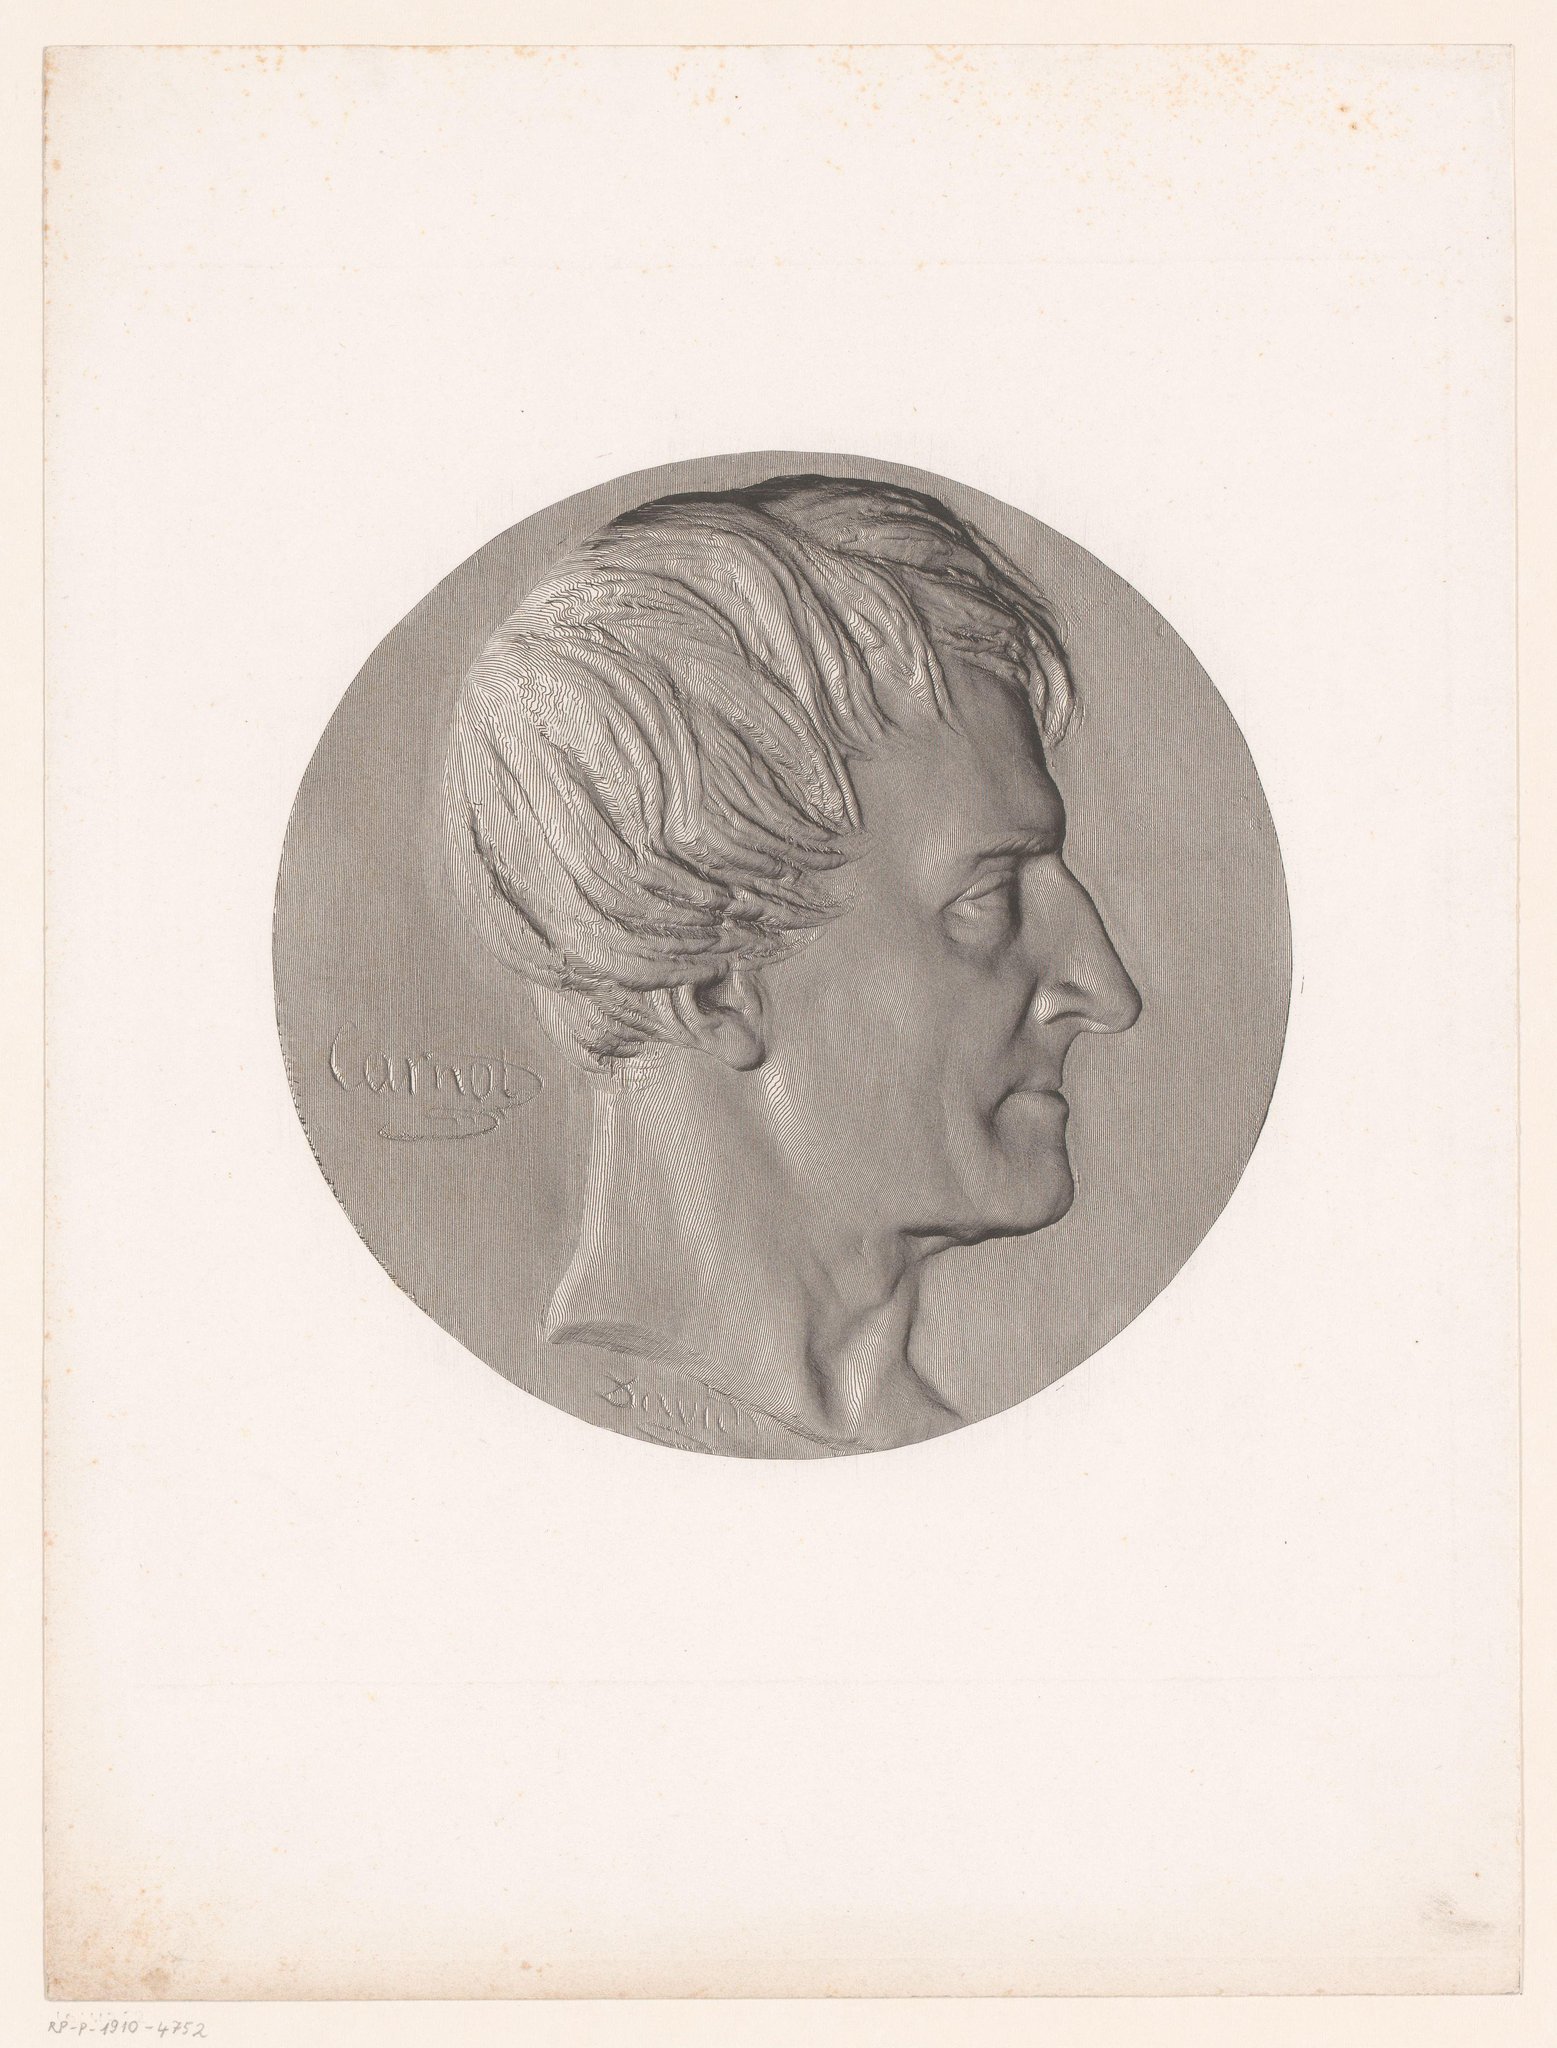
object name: print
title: Medaillon met portret van Lazare Carnot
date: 1820-1840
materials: paper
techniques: relief engraving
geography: france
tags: ornament ~ medallion, historical persons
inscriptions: collector's mark: Lugt 2228